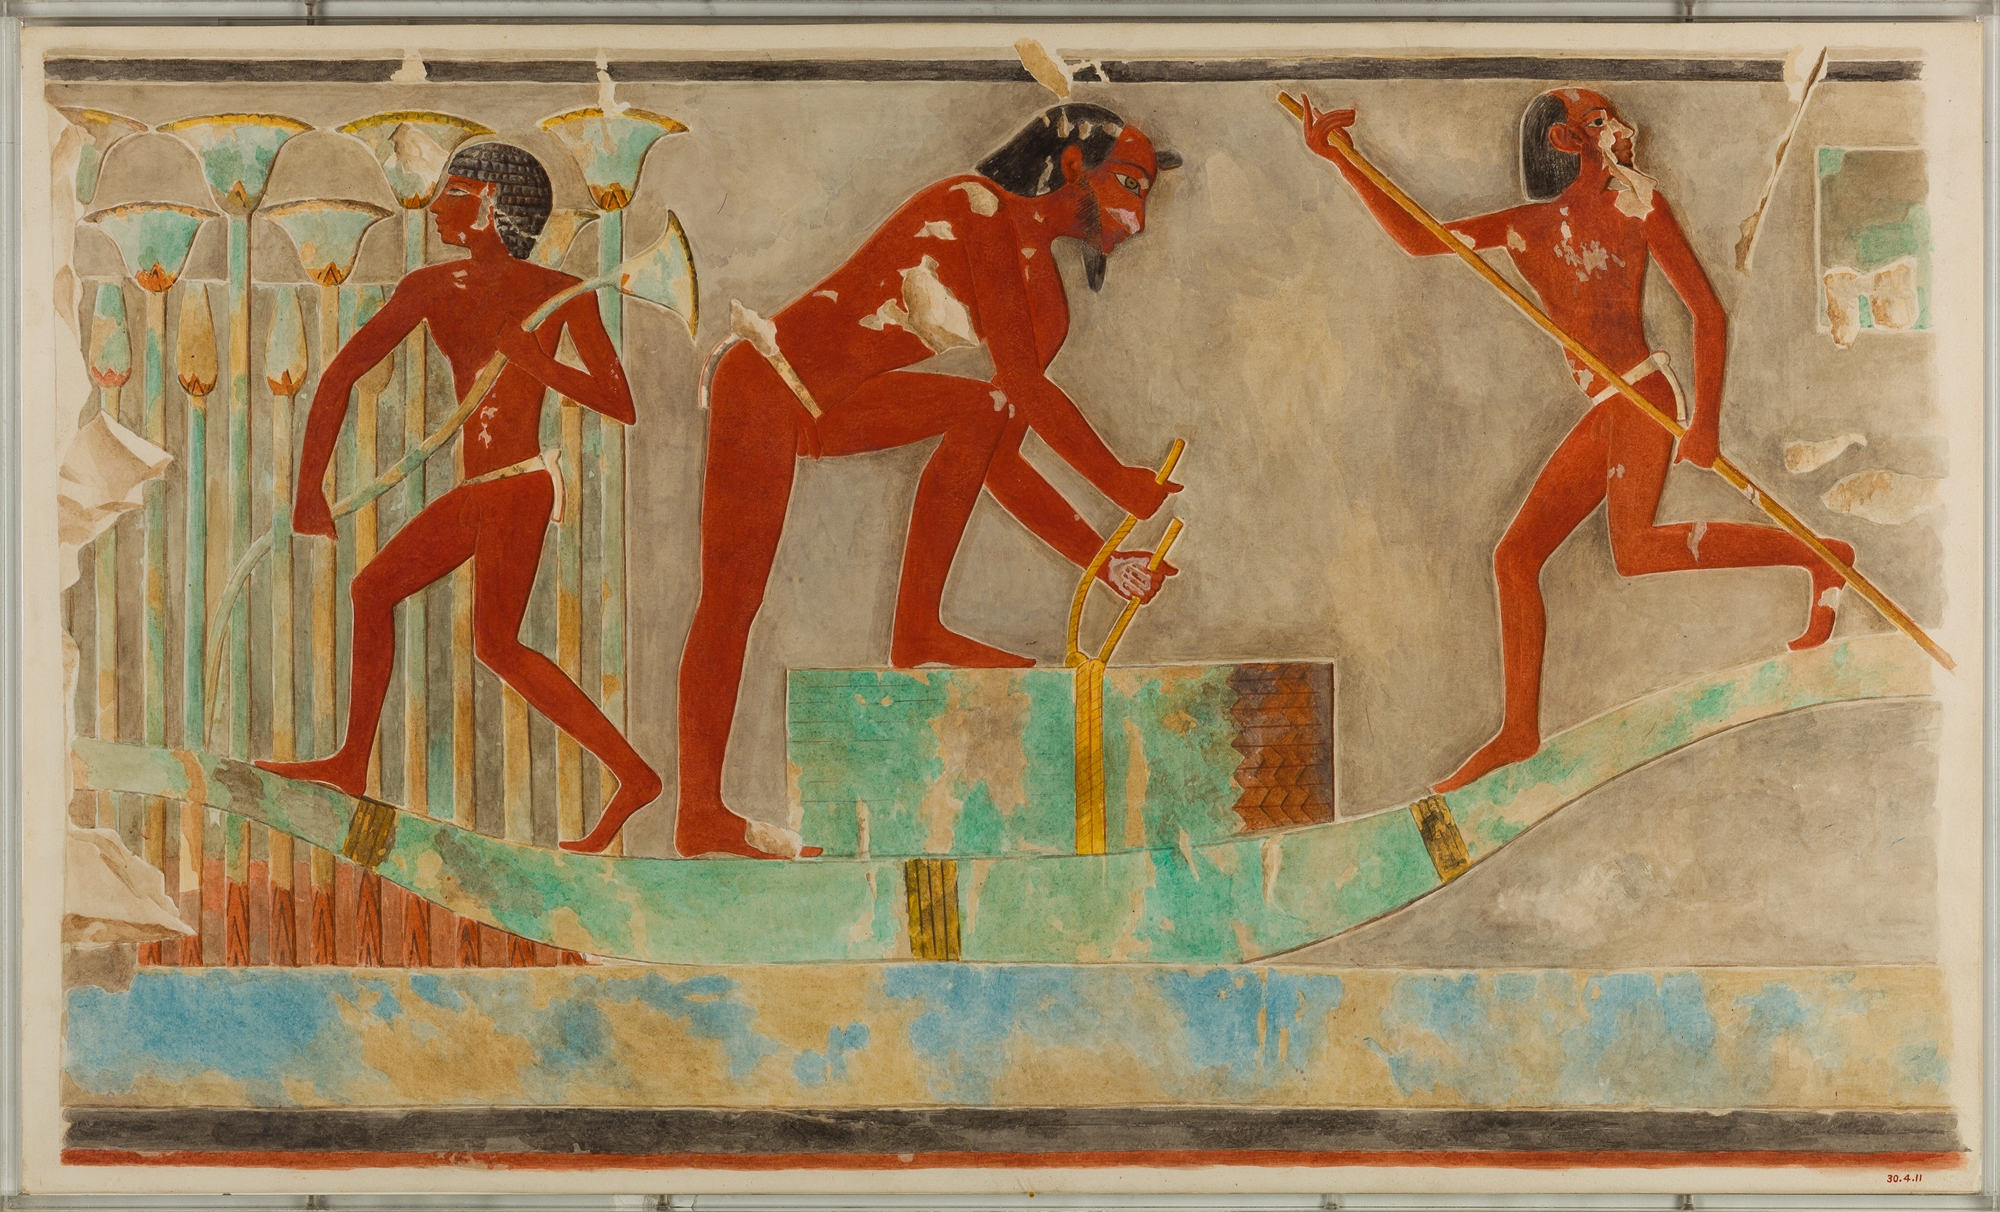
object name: facsimile, puyemre tt 39, papyrus industry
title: Men Gathering Papyrus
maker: hugh r. hopgood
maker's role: artist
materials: paper, paint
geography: egypt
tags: men,working,walk-like-egyptian